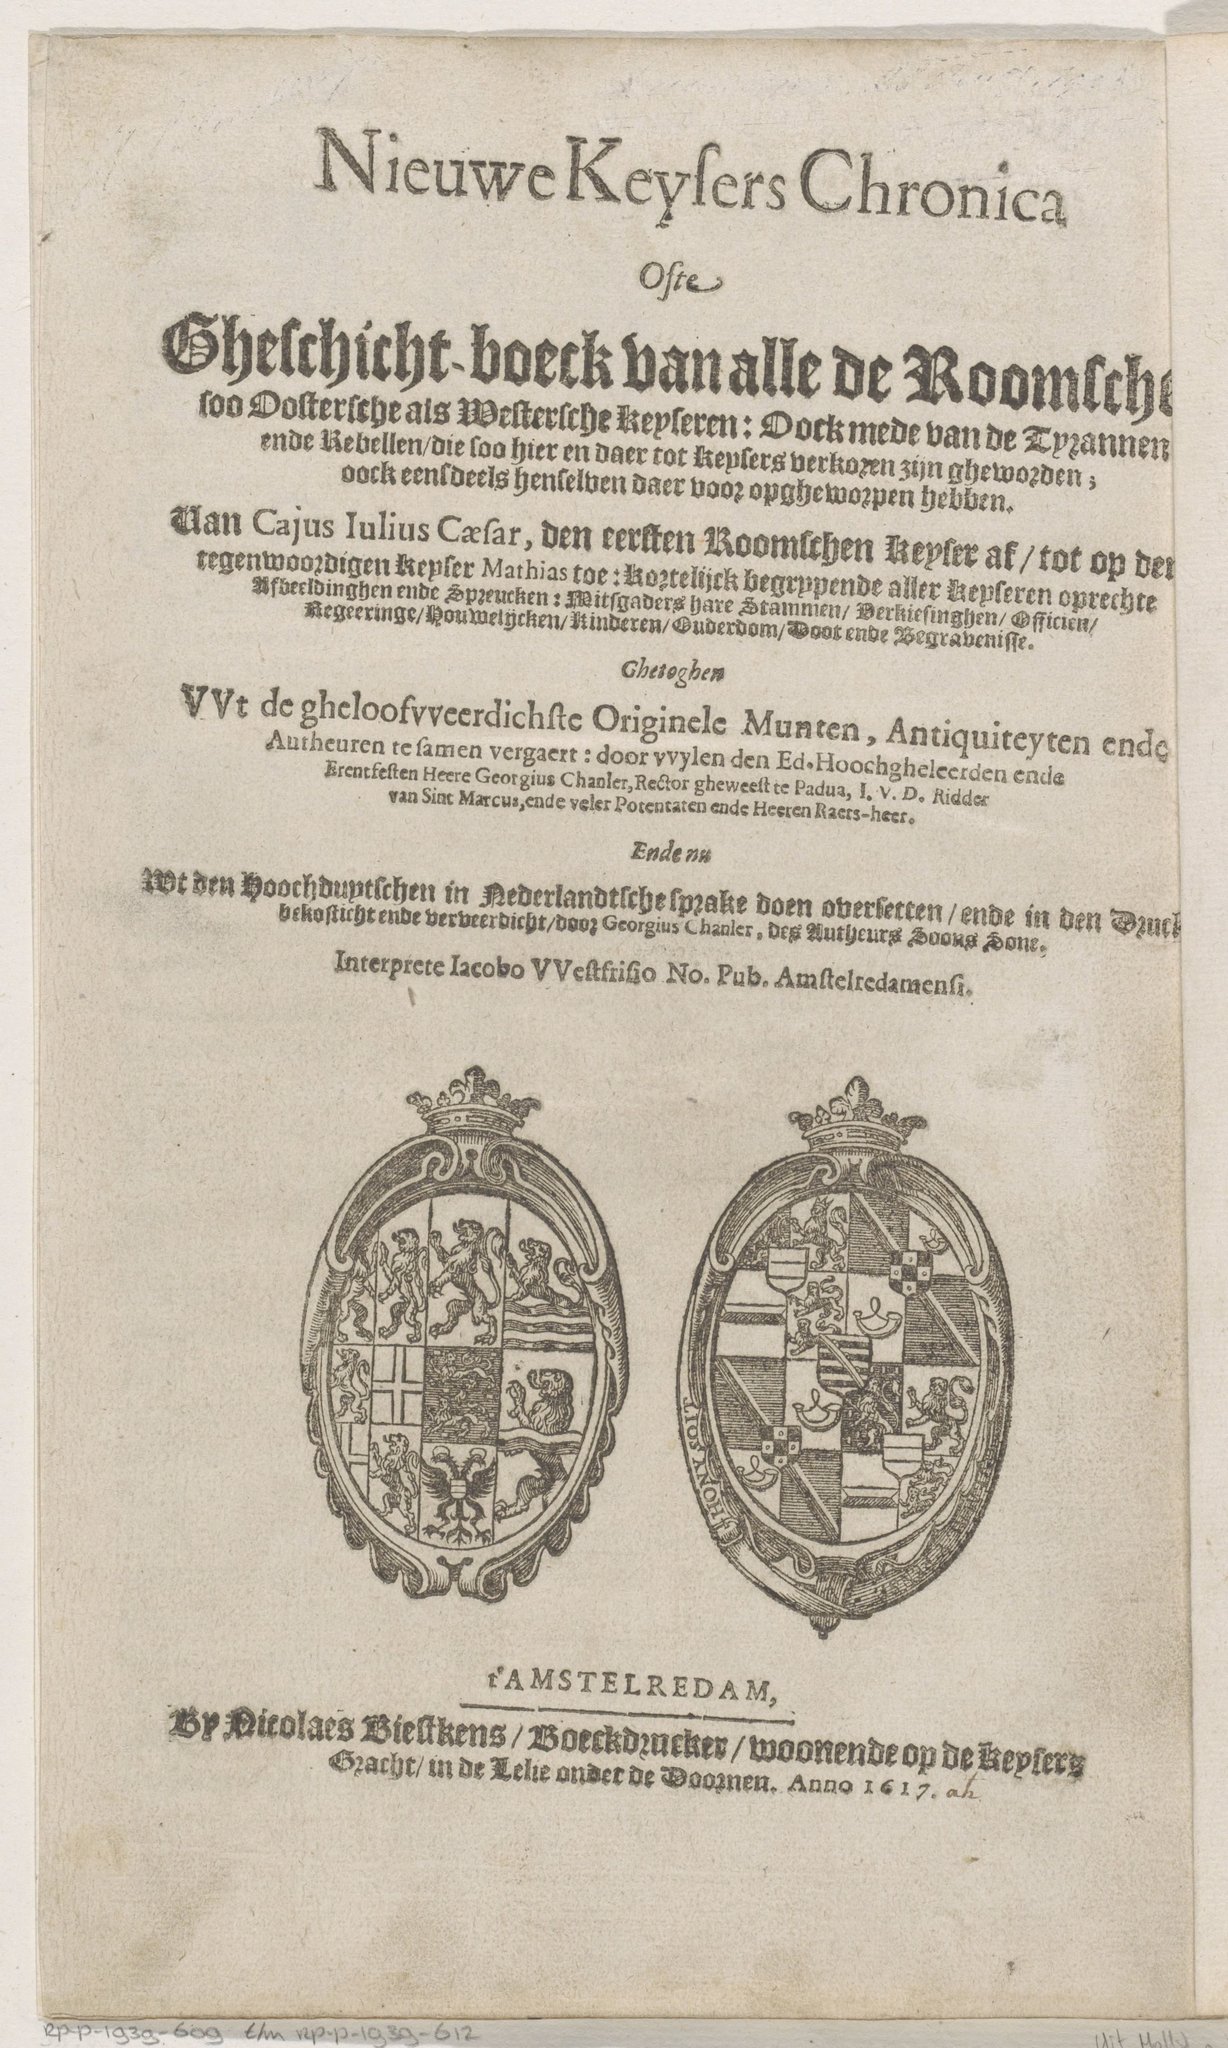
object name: titelblad, titelpagina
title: Titelpagina voor: Georgius Chanler, Nieuwe keysers chronica ofte Gheschicht-boeck van alle de roomsche, soo oostersche als westersche keyseren, 1617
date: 1617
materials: paper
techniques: letterpress printing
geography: amsterdam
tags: the hague, maurice (prince of orange), emperor, coat of arms (as symbol of the state, etc.) (+ province; provincial), armorial bearing, heraldry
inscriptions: collector's mark: Lugt 2760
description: Titelpagina voor: Chanler, Georgius. Nieuwe keysers chronica ofte Gheschicht-boeck van alle de roomsche, soo oostersche als westersche keyseren. Amsterdam: Nicolaes Biestkens, 1617.